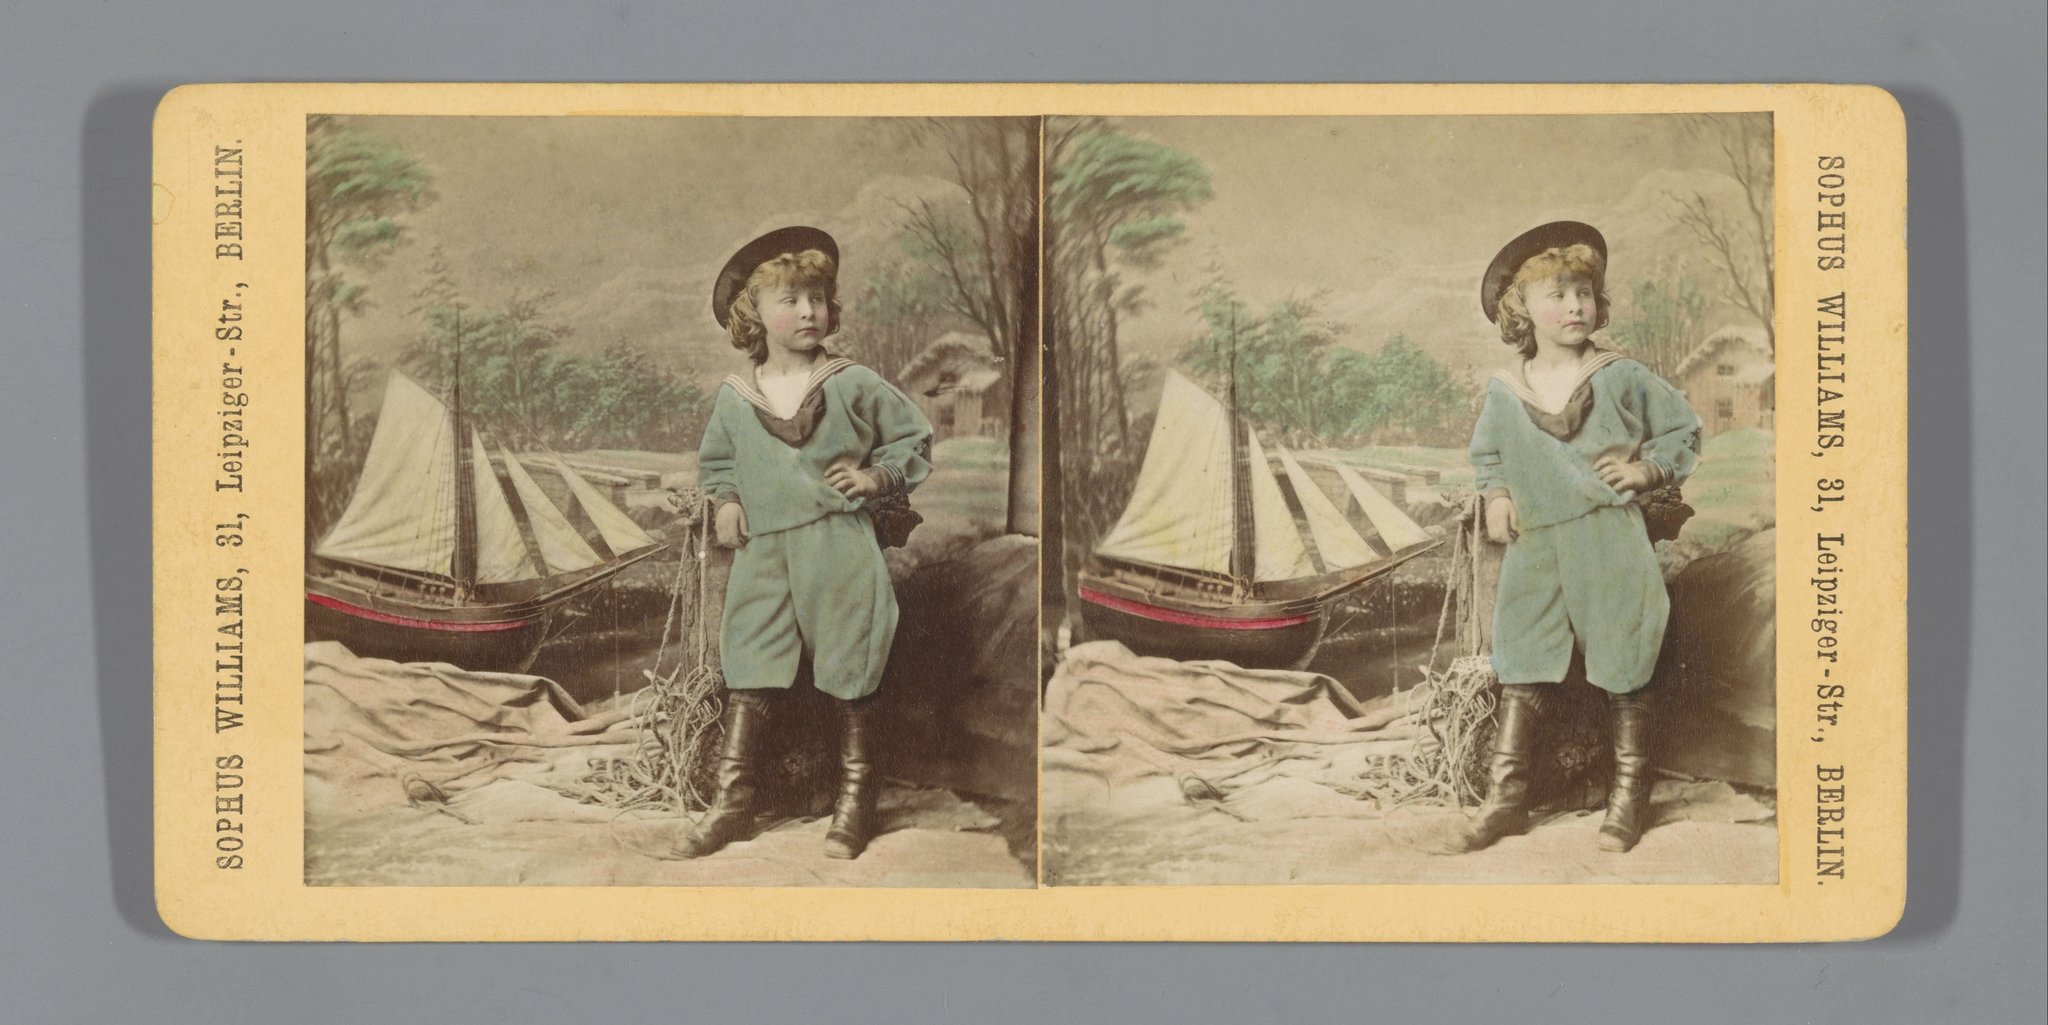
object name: stereograph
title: Portret van een jongetje voor een decor met schip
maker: sophus williams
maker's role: publisher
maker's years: 1835-1900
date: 1873-1890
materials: cardboard, paper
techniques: albumen print, hand coloring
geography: berlin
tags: boy (child between toddler and youth), ships (in general), anonymous historical person portrayed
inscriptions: number: ‘50’